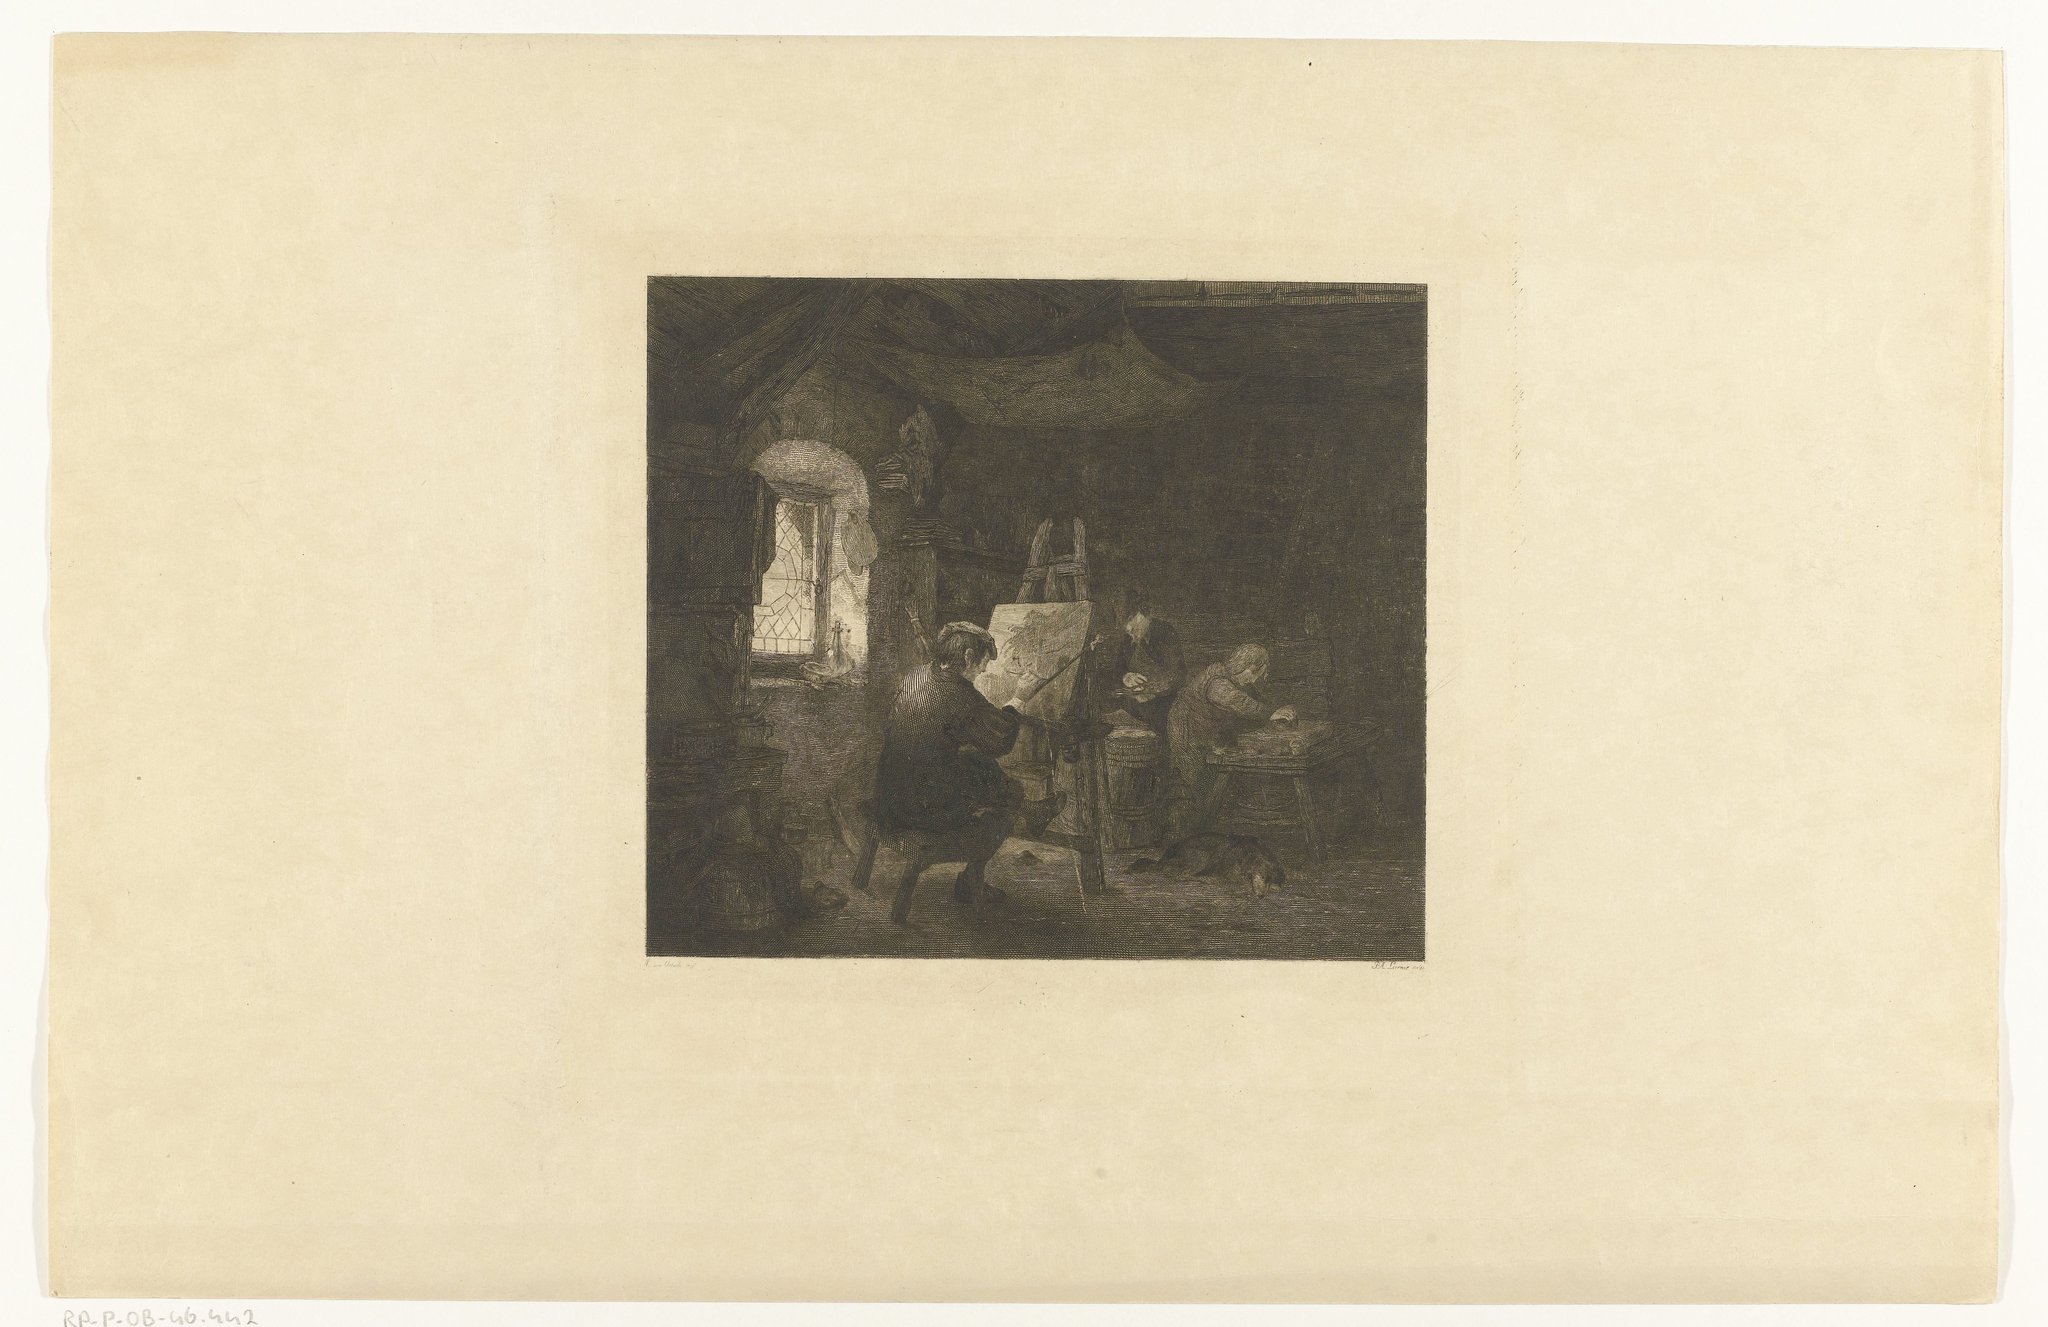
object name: print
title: Schilder in zijn atelier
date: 1841-1857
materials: paper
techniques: etching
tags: painter at work, in his studio, painter preparing colours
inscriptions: collector's mark: Lugt 2228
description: Een schilder aan het werk in zijn atelier. Hij zit achter een ezel bij het raam, hierachter bereiden twee assistenten of leerlingen verf.